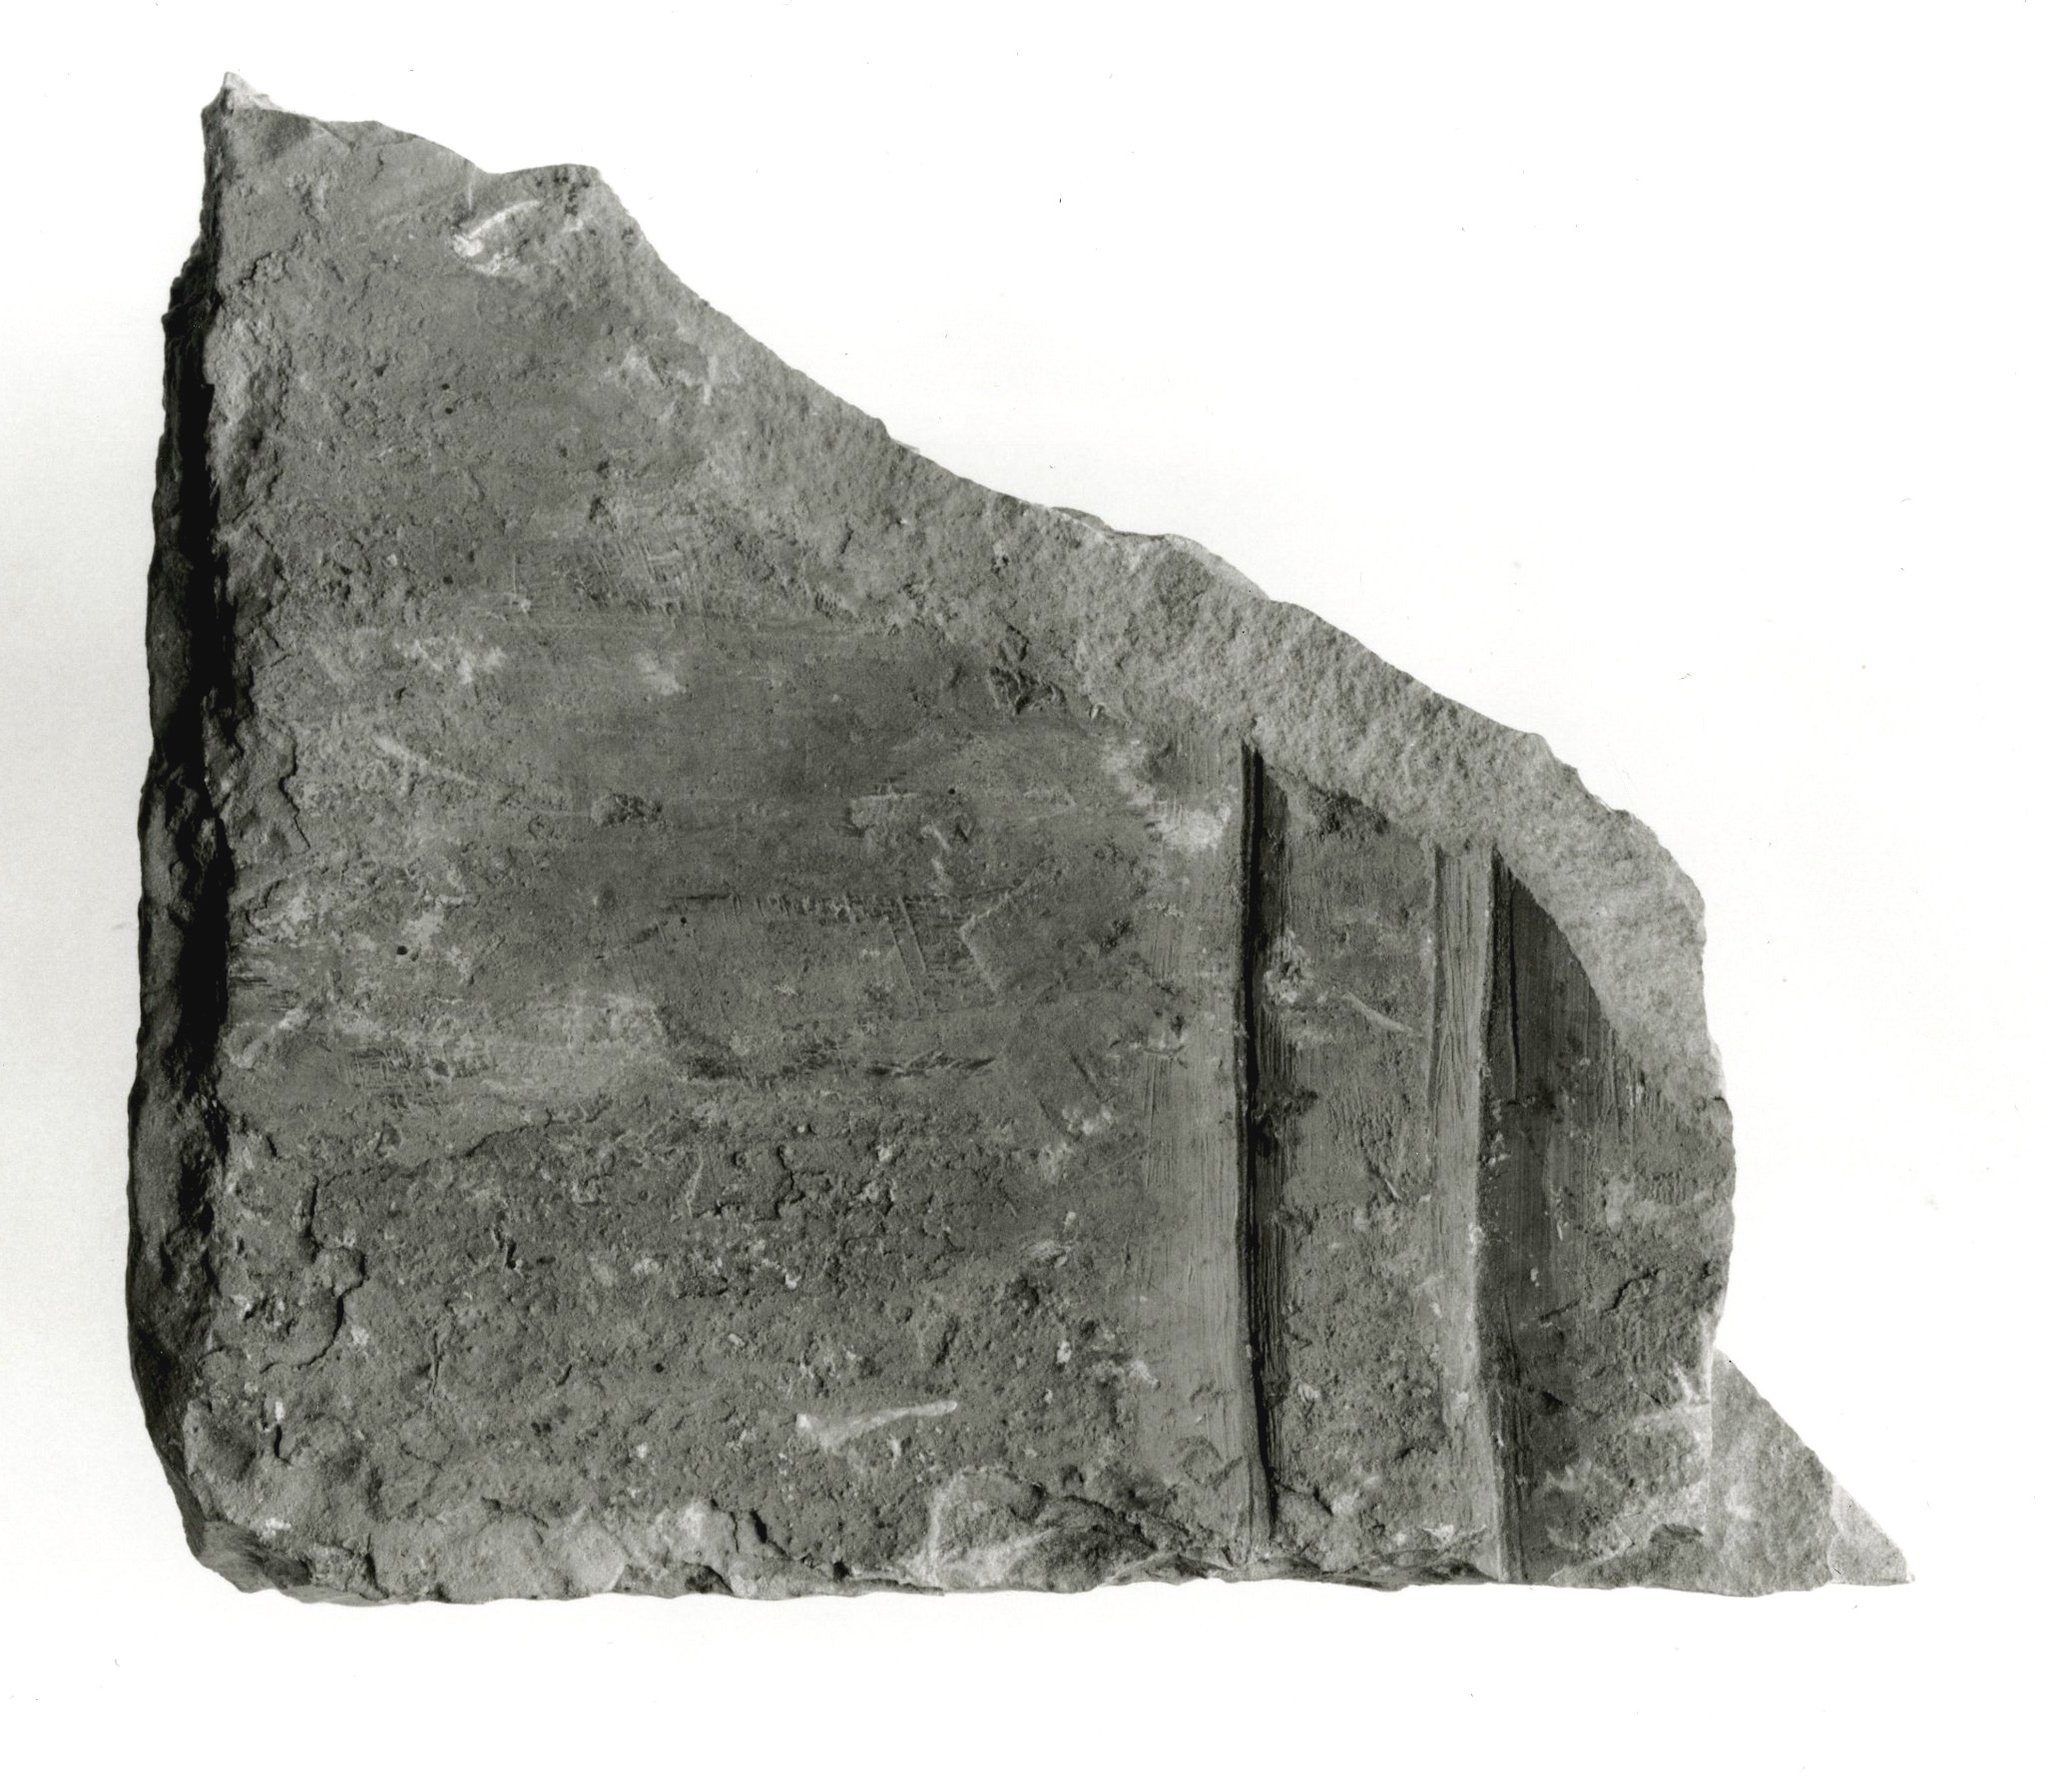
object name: relief, tomb of nespekashuty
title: Raised relief fragment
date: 664-610 BCE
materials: limestone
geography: egypt